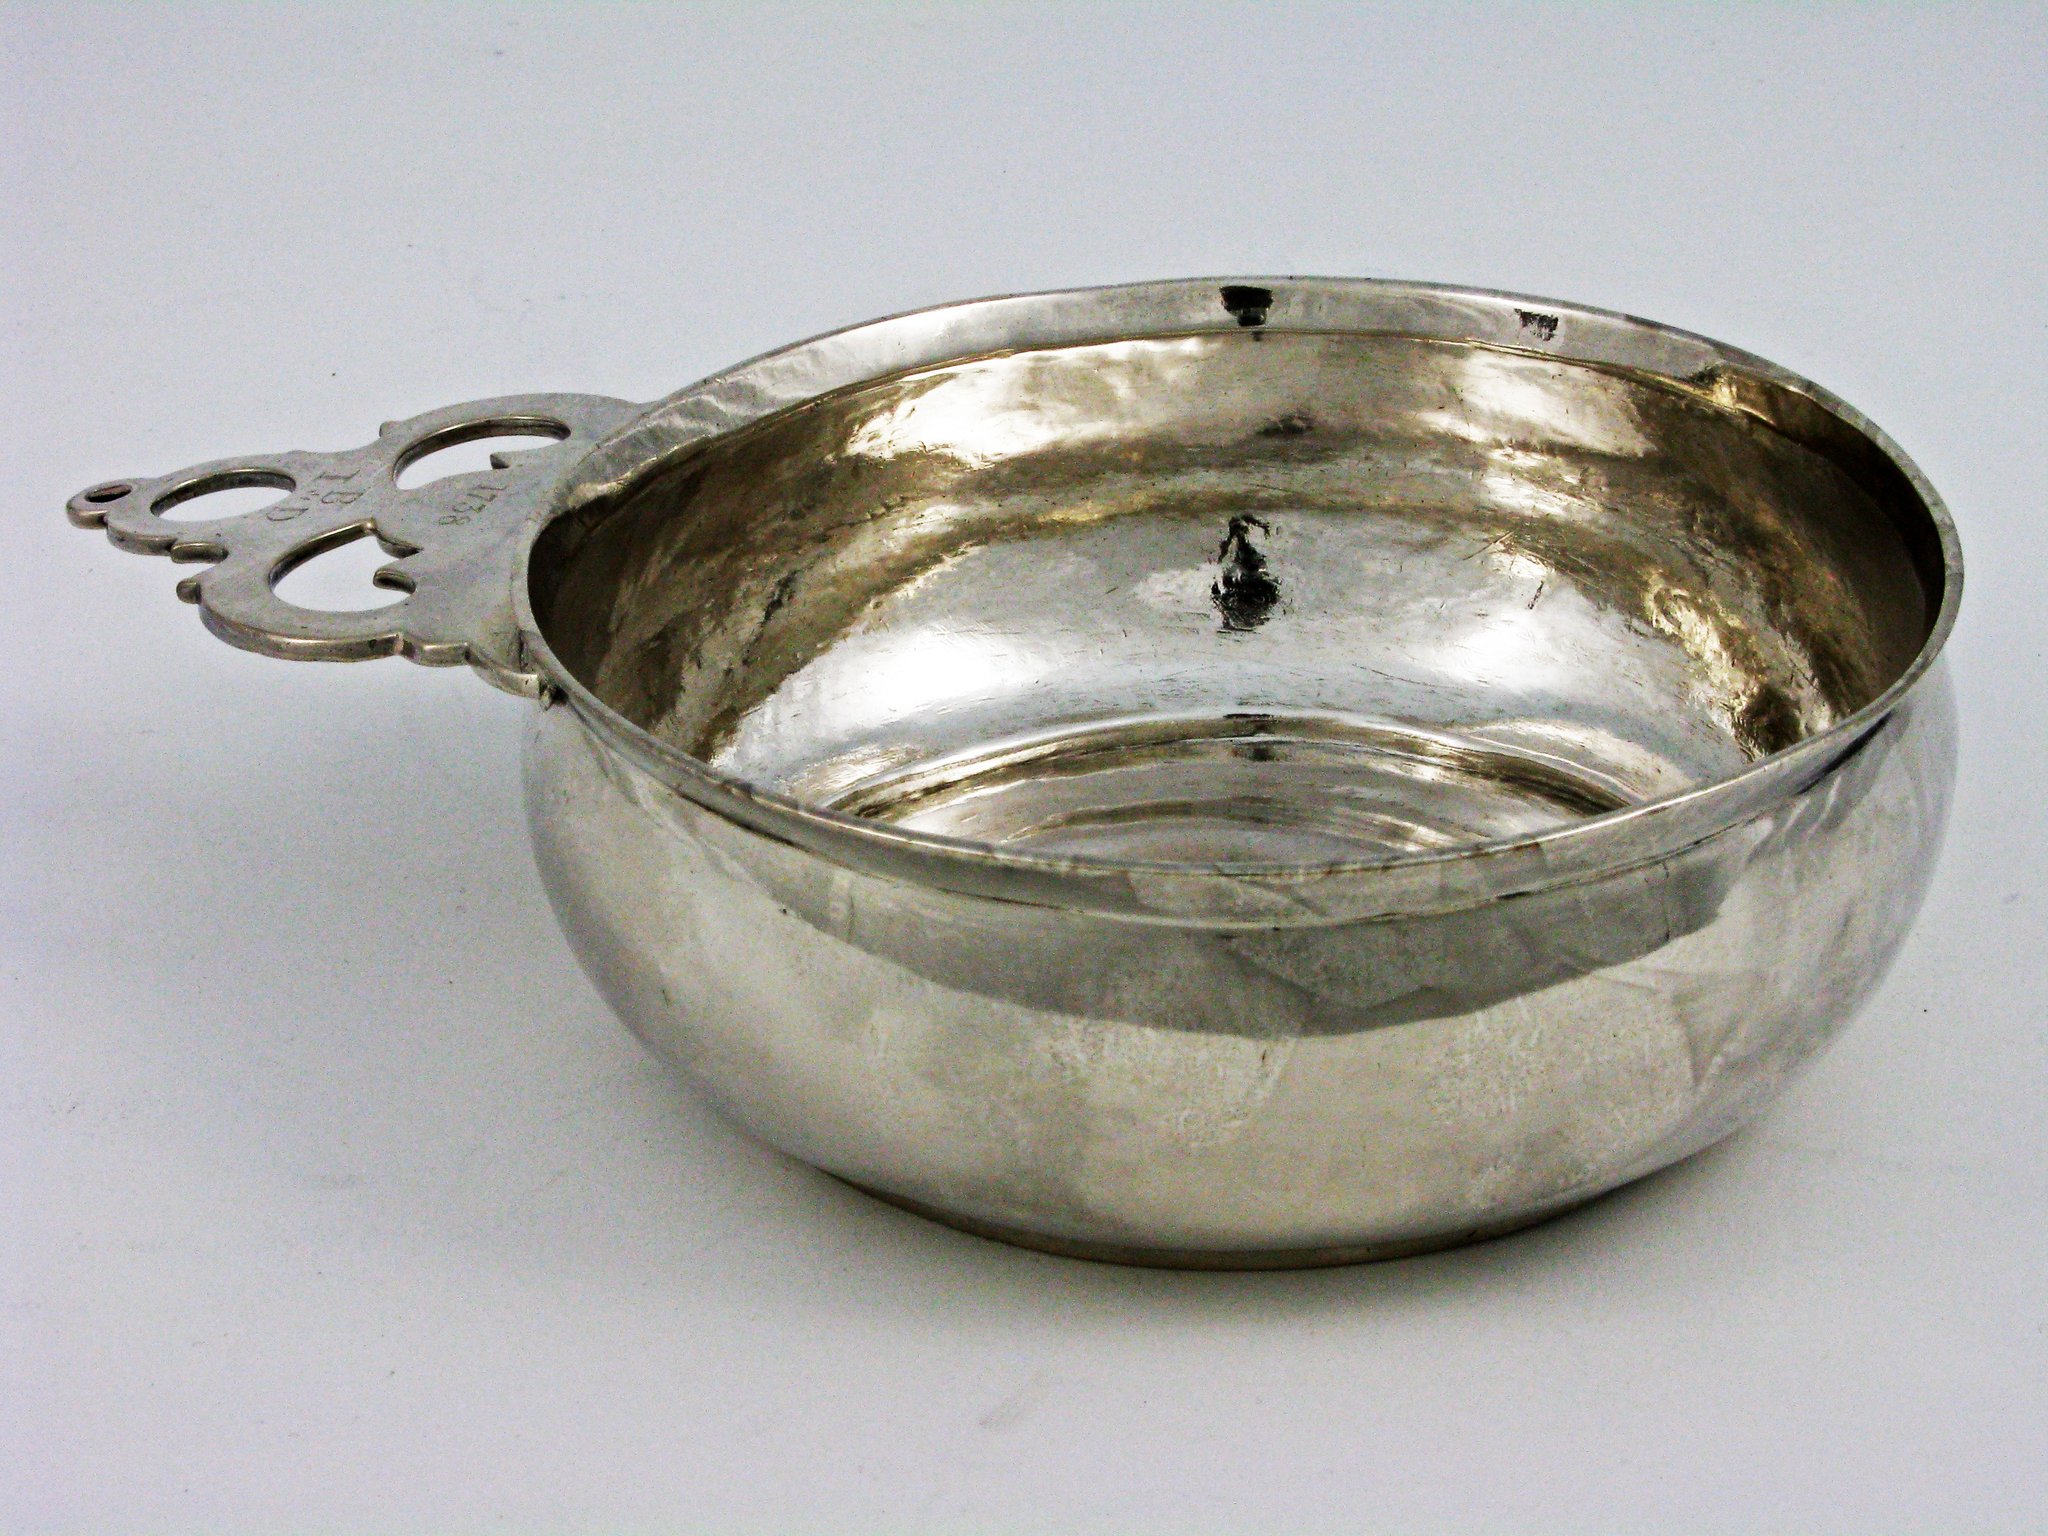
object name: porringer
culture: american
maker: john brevoort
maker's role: maker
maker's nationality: american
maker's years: 1715-1775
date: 1738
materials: silver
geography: united states